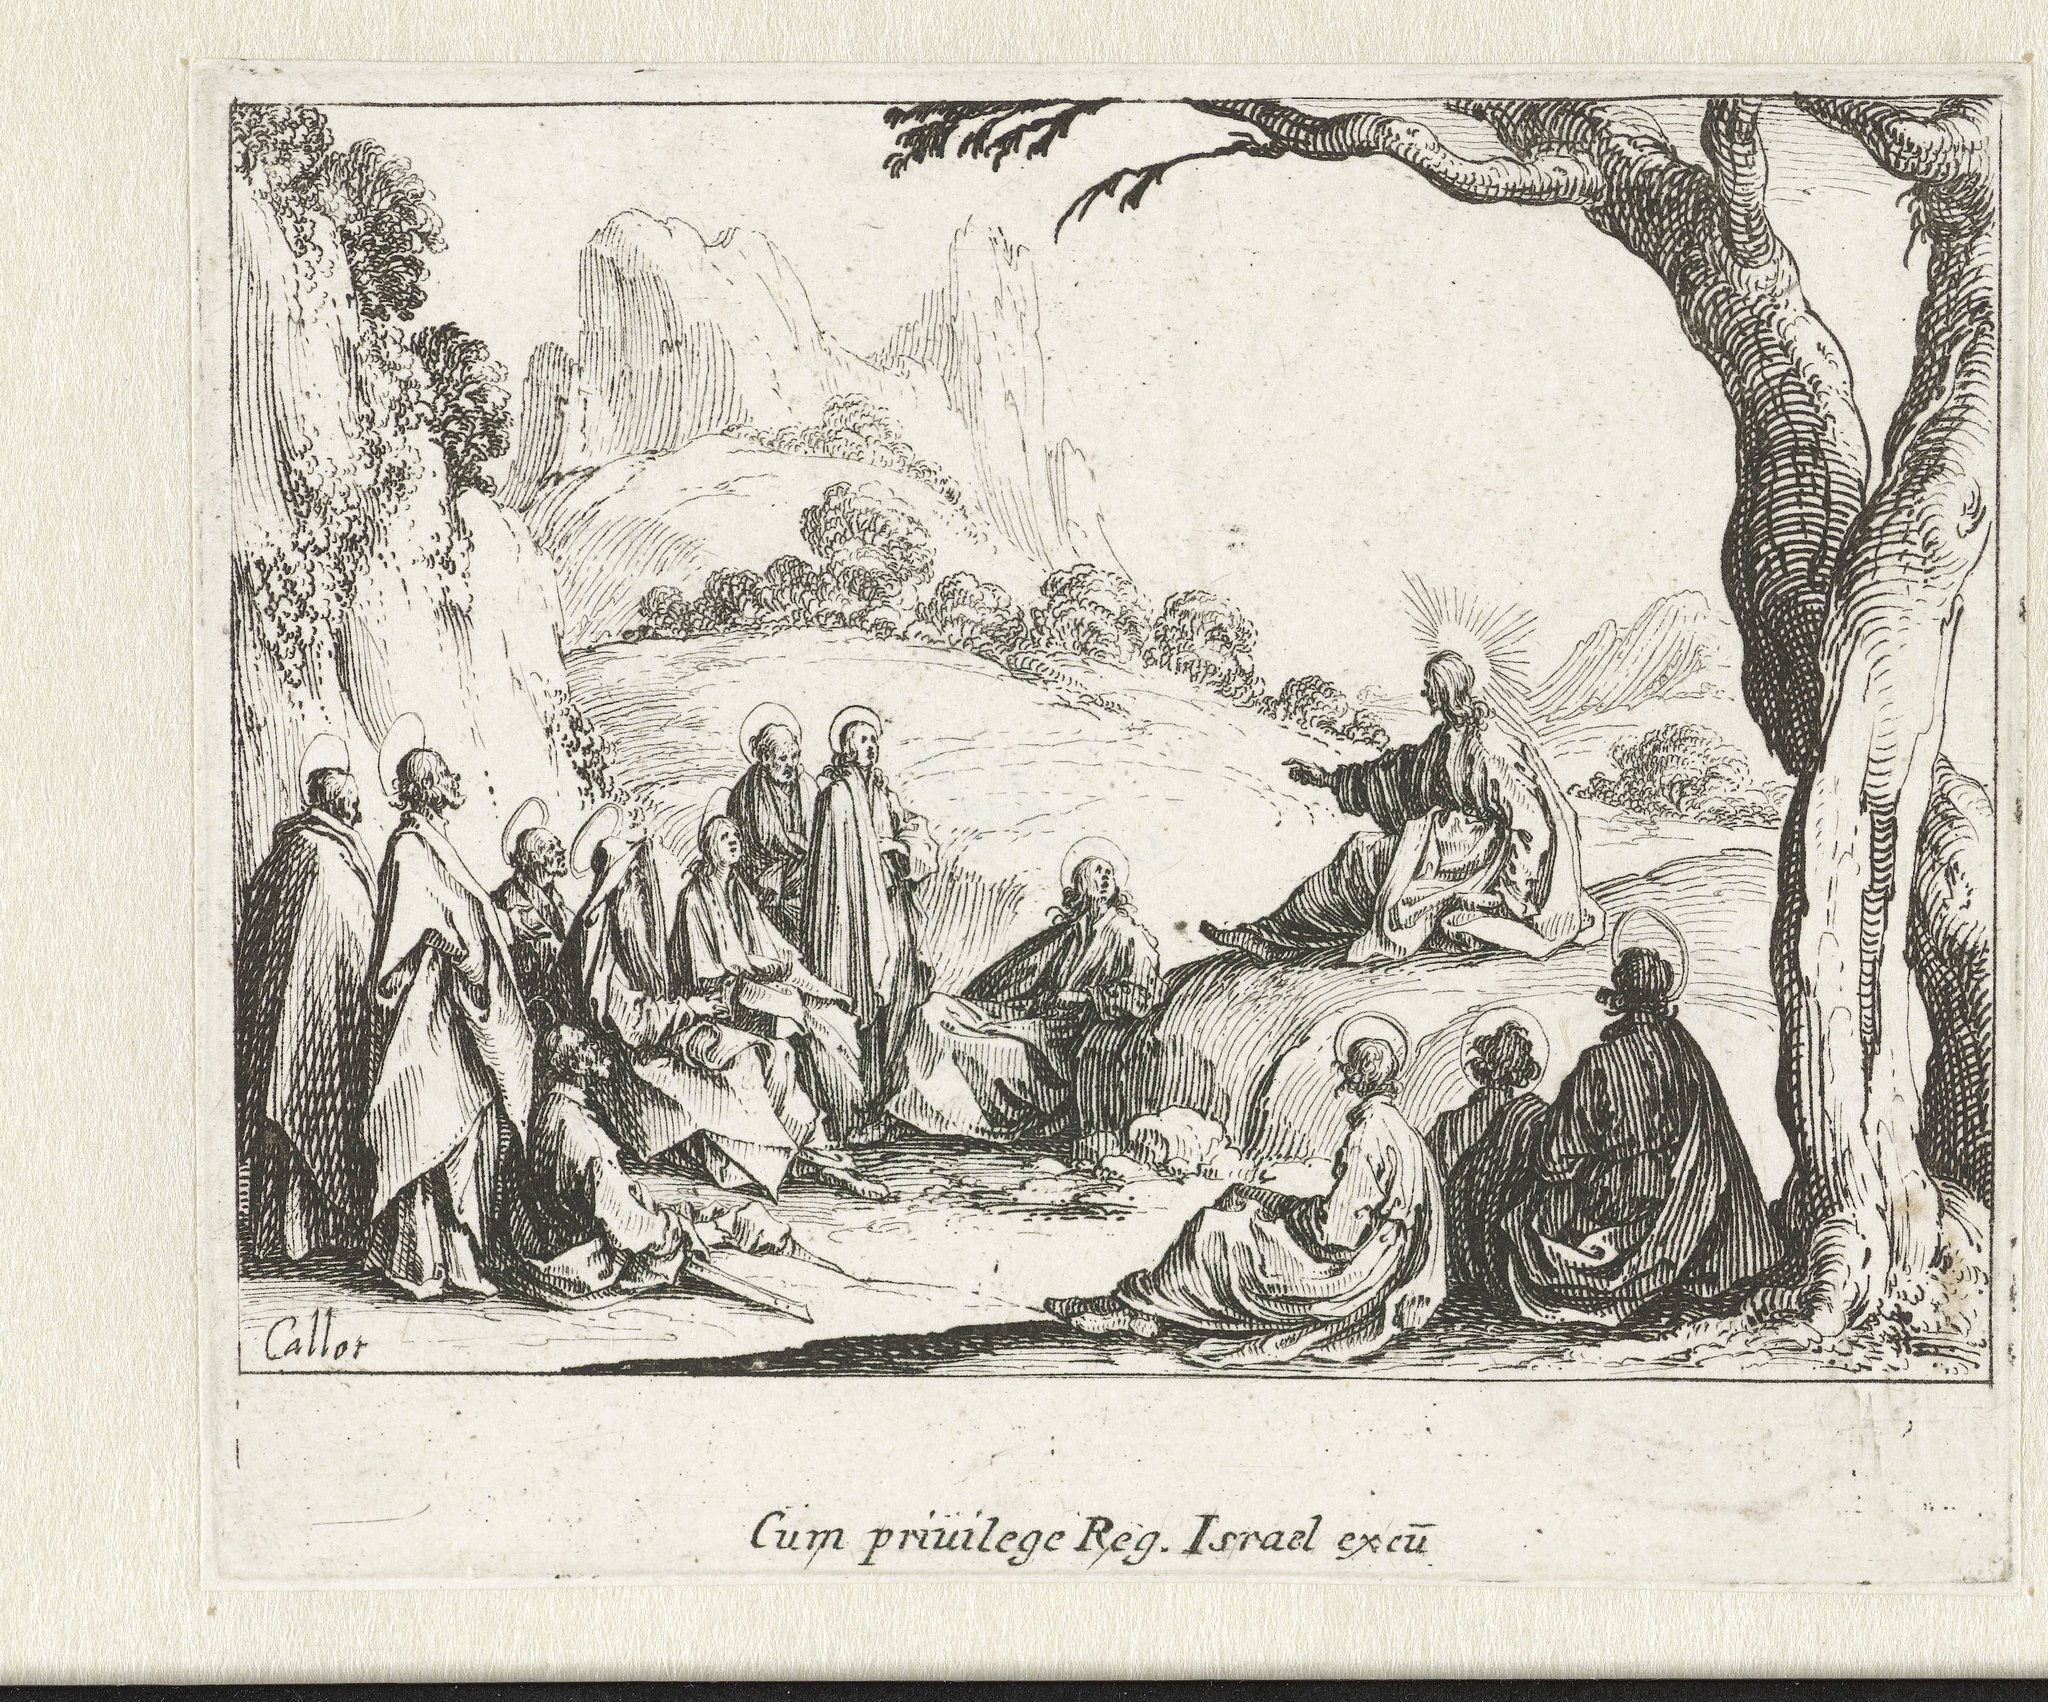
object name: print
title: Bergrede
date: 1635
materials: paper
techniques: etching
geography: paris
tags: christ's sermon on the mount (matthew 5-7), christ preaching in the open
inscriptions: collector's mark: Lugt 240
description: Christus zit op een rots in een bergachtige omgeving, en spreekt tot zijn discipelen, die aan de voet van de rots zitten en staan. Deze prent is onderdeel van een reeks van tien prenten met voorstellingen uit het Nieuwe Testament, waaraan na Callots dood een titelprent is toegevoegd.